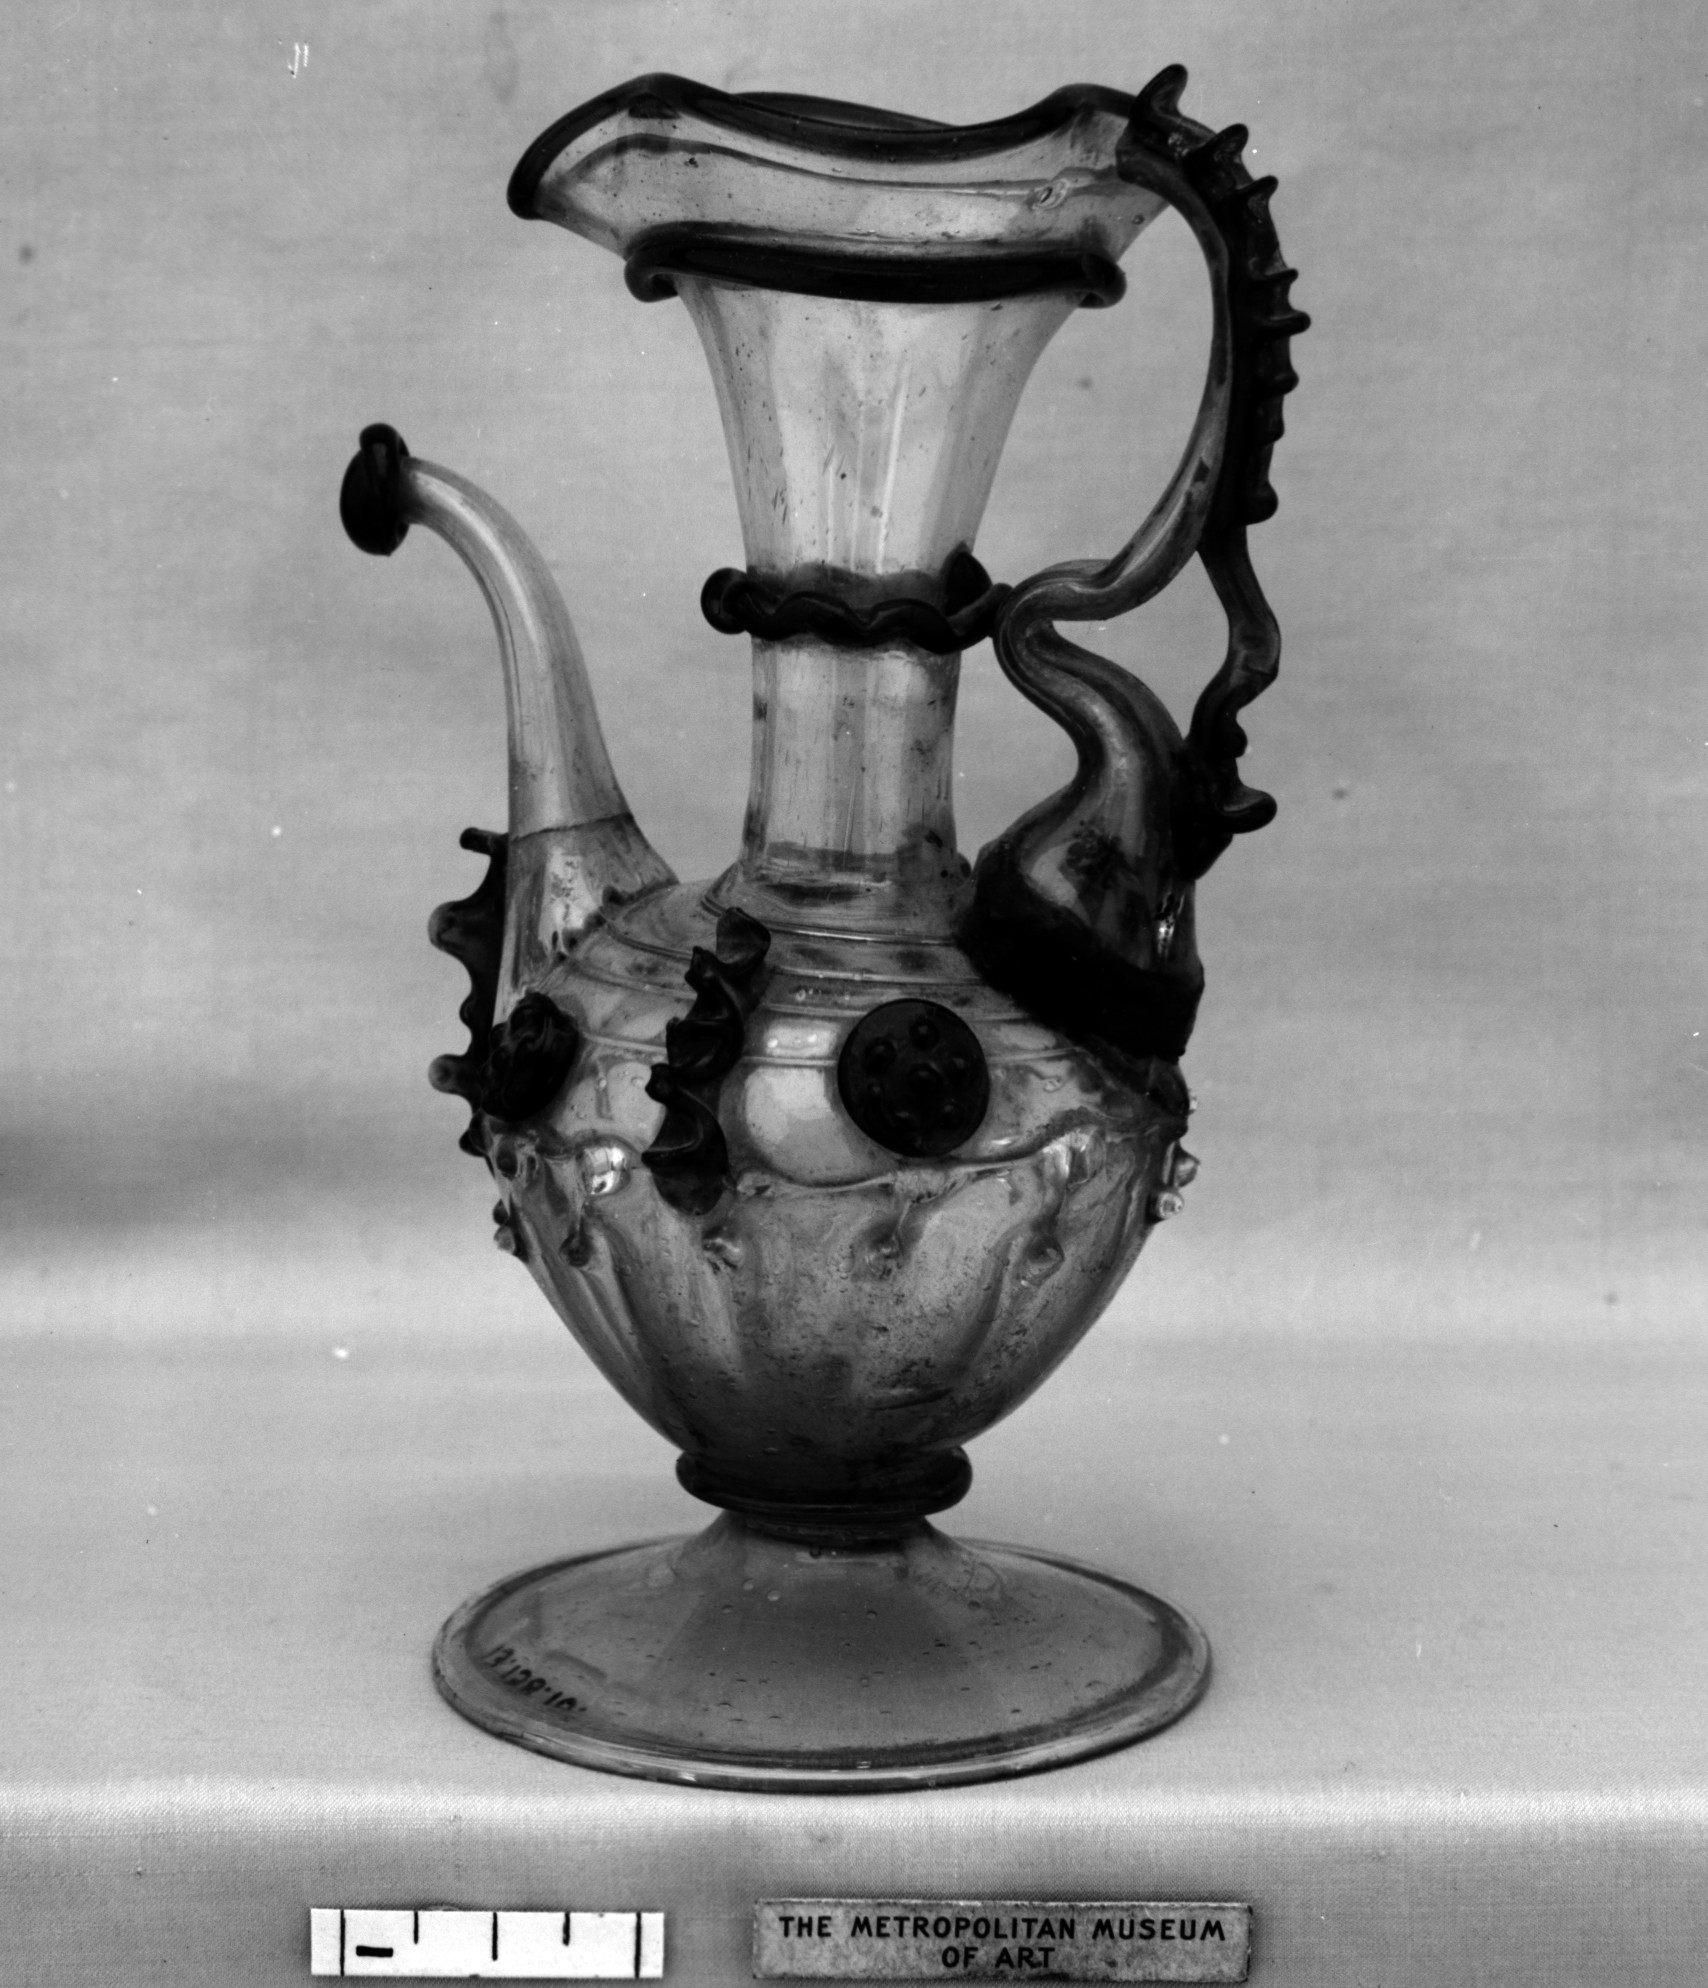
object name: cruet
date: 1501-1700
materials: glass